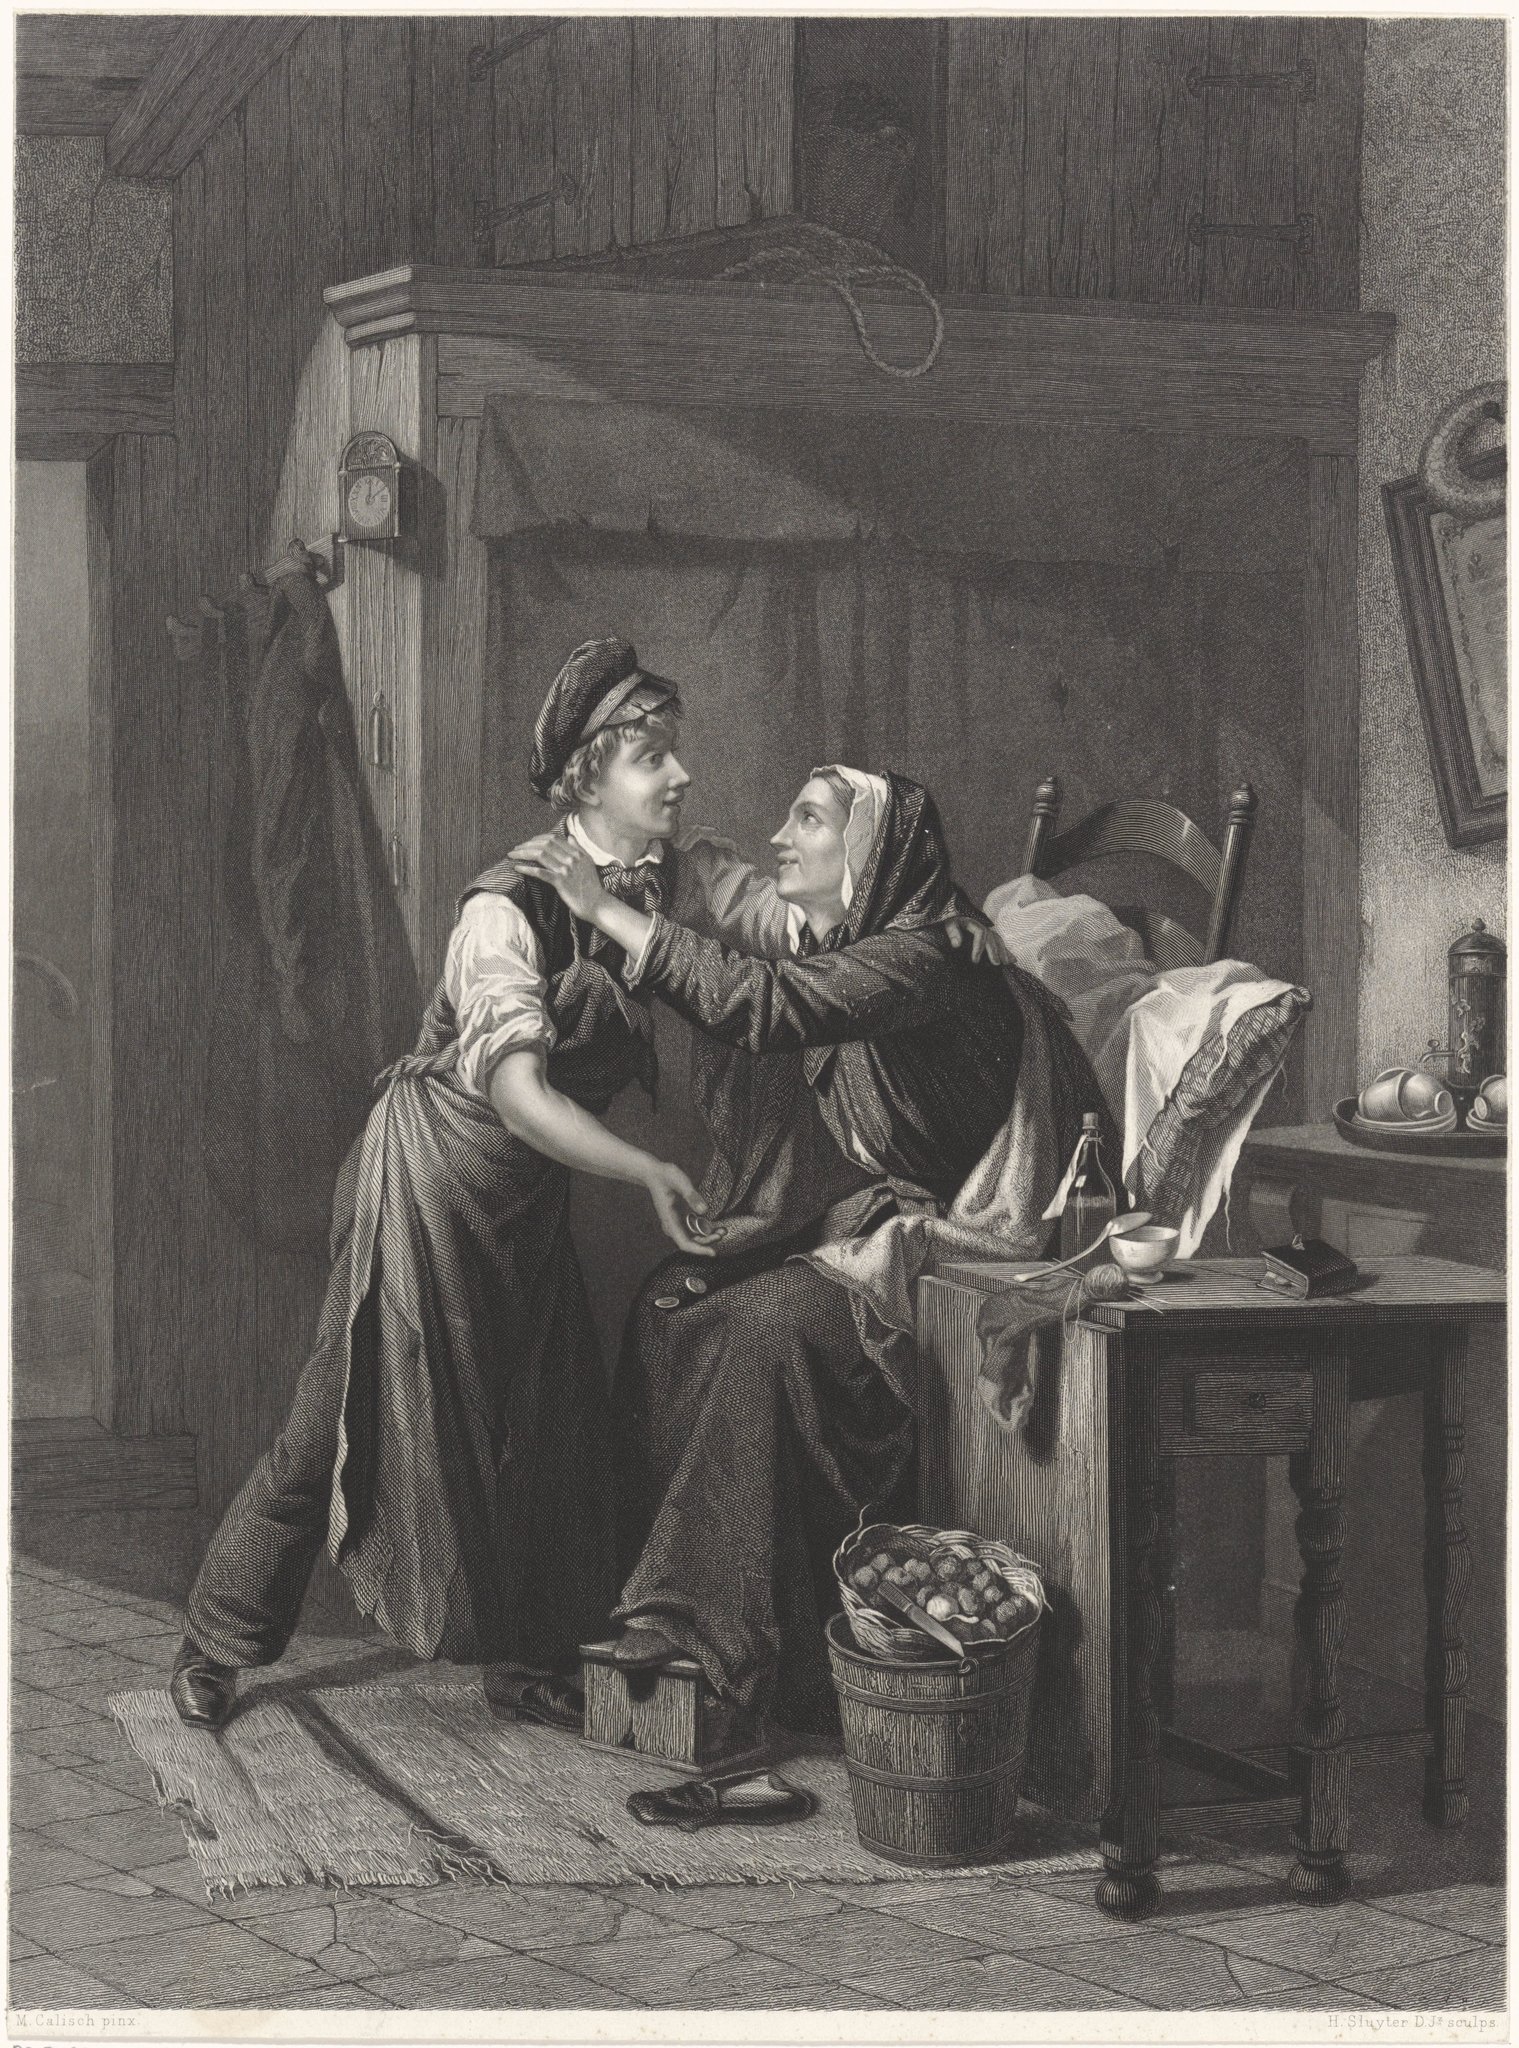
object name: print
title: Vrouw omarmt jongen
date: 1854-1931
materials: paper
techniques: aquatint, engraving, etching, roulette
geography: amsterdam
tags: coffee-pot, unequal couple, ill-matched couple, book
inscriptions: collector's mark: Lugt 2228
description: In een eenvoudig interieur zit een oudere, zieke vrouw op een stoel met haar voeten op een stoof en een kussen in de rug. Zij omarmt een jongeman met een pet op, die geld in haar schoot werpt. Op de tafel naast haar liggen een boek en een breiwerkje. Ernaast een kom met lepel. Op de grond een mand met knollen of aardappelen en een schilmesje.Achter haar op een tafeltje een koffiestel met kopjes.